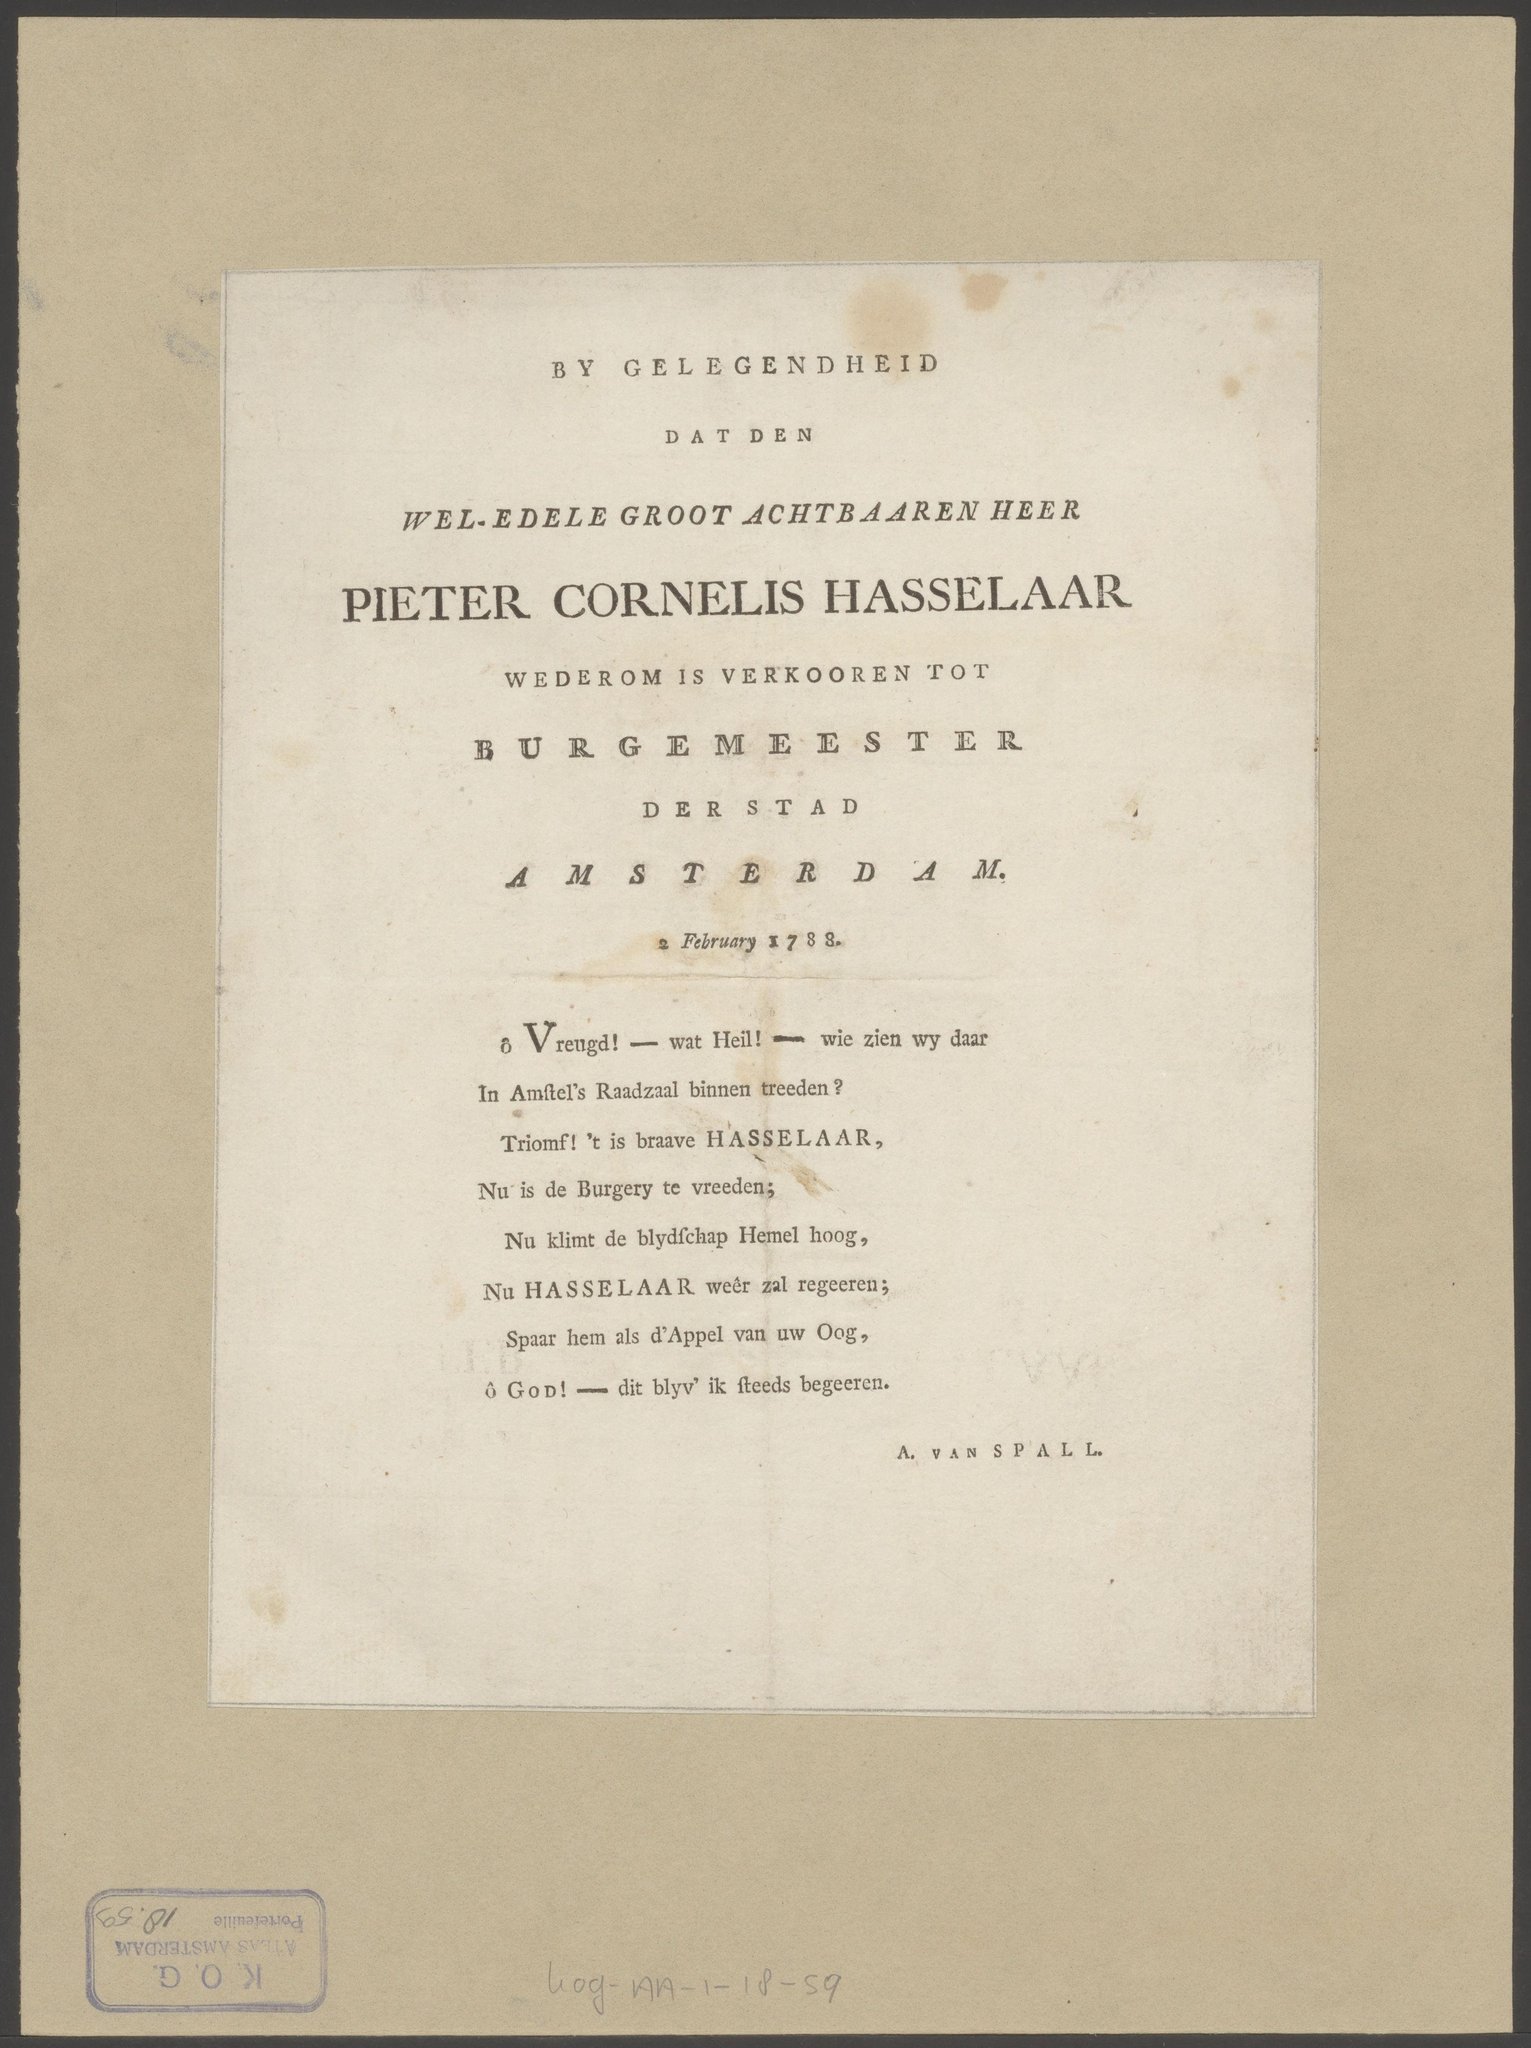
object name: text sheet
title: Gedicht op de installatie van Pieter Cornelis Hasselaar als burgemeester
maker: Anonymous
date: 1788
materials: paper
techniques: letterpress printing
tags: pieter cornelis hasselaer, mayor, burgomaster, amsterdam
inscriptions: name: ‘A. van Spall’, collector's mark: ‘18.59’ Lugt 1641b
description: Onderwerpsrubriek binnen de Atlas Amsterdam: Herinneringen aan regeringsleden en hunne huisgezinnen [voor 1800].